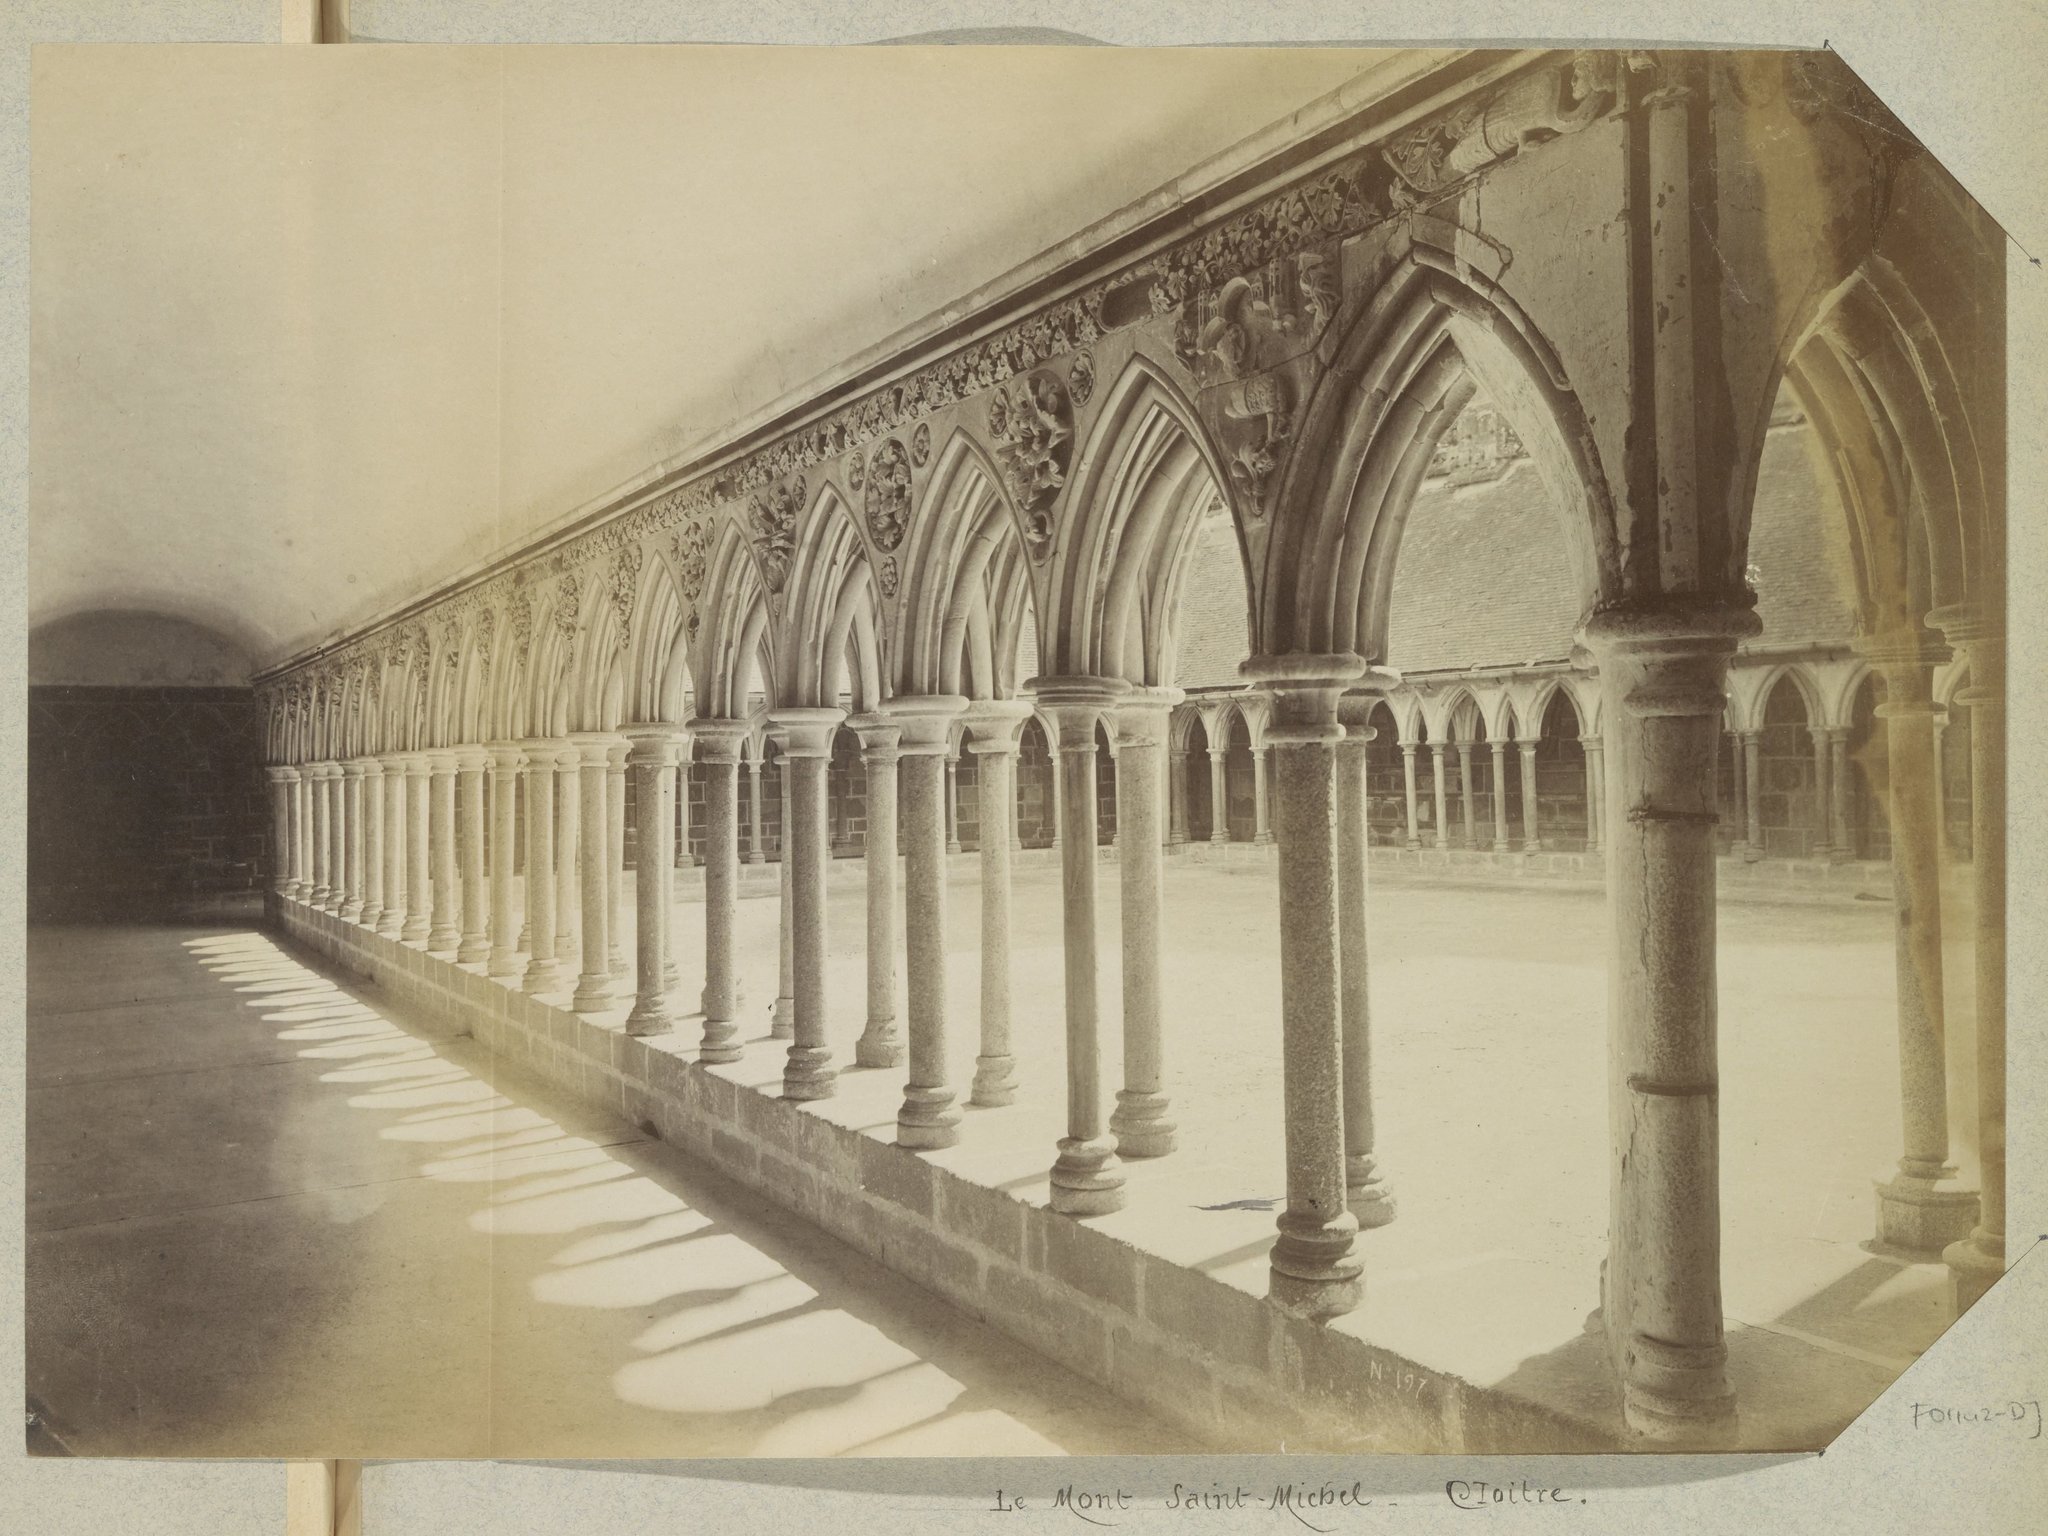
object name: album leaf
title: Gezicht op de kloostergangen van Mont Saint-Michel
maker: Anonymous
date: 1880-1900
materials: paper, photographic support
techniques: albumen print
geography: france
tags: abbey, monastery, convent ~ roman catholic church, cloisters ~ monastery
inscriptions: negative number: ‘197’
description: Onderdeel van Album van een Franse amateur met foto's van Frankrijk, Algerije, Palmyra, de Wereldtentoonstelling van 1900 en van bekende Fransen.